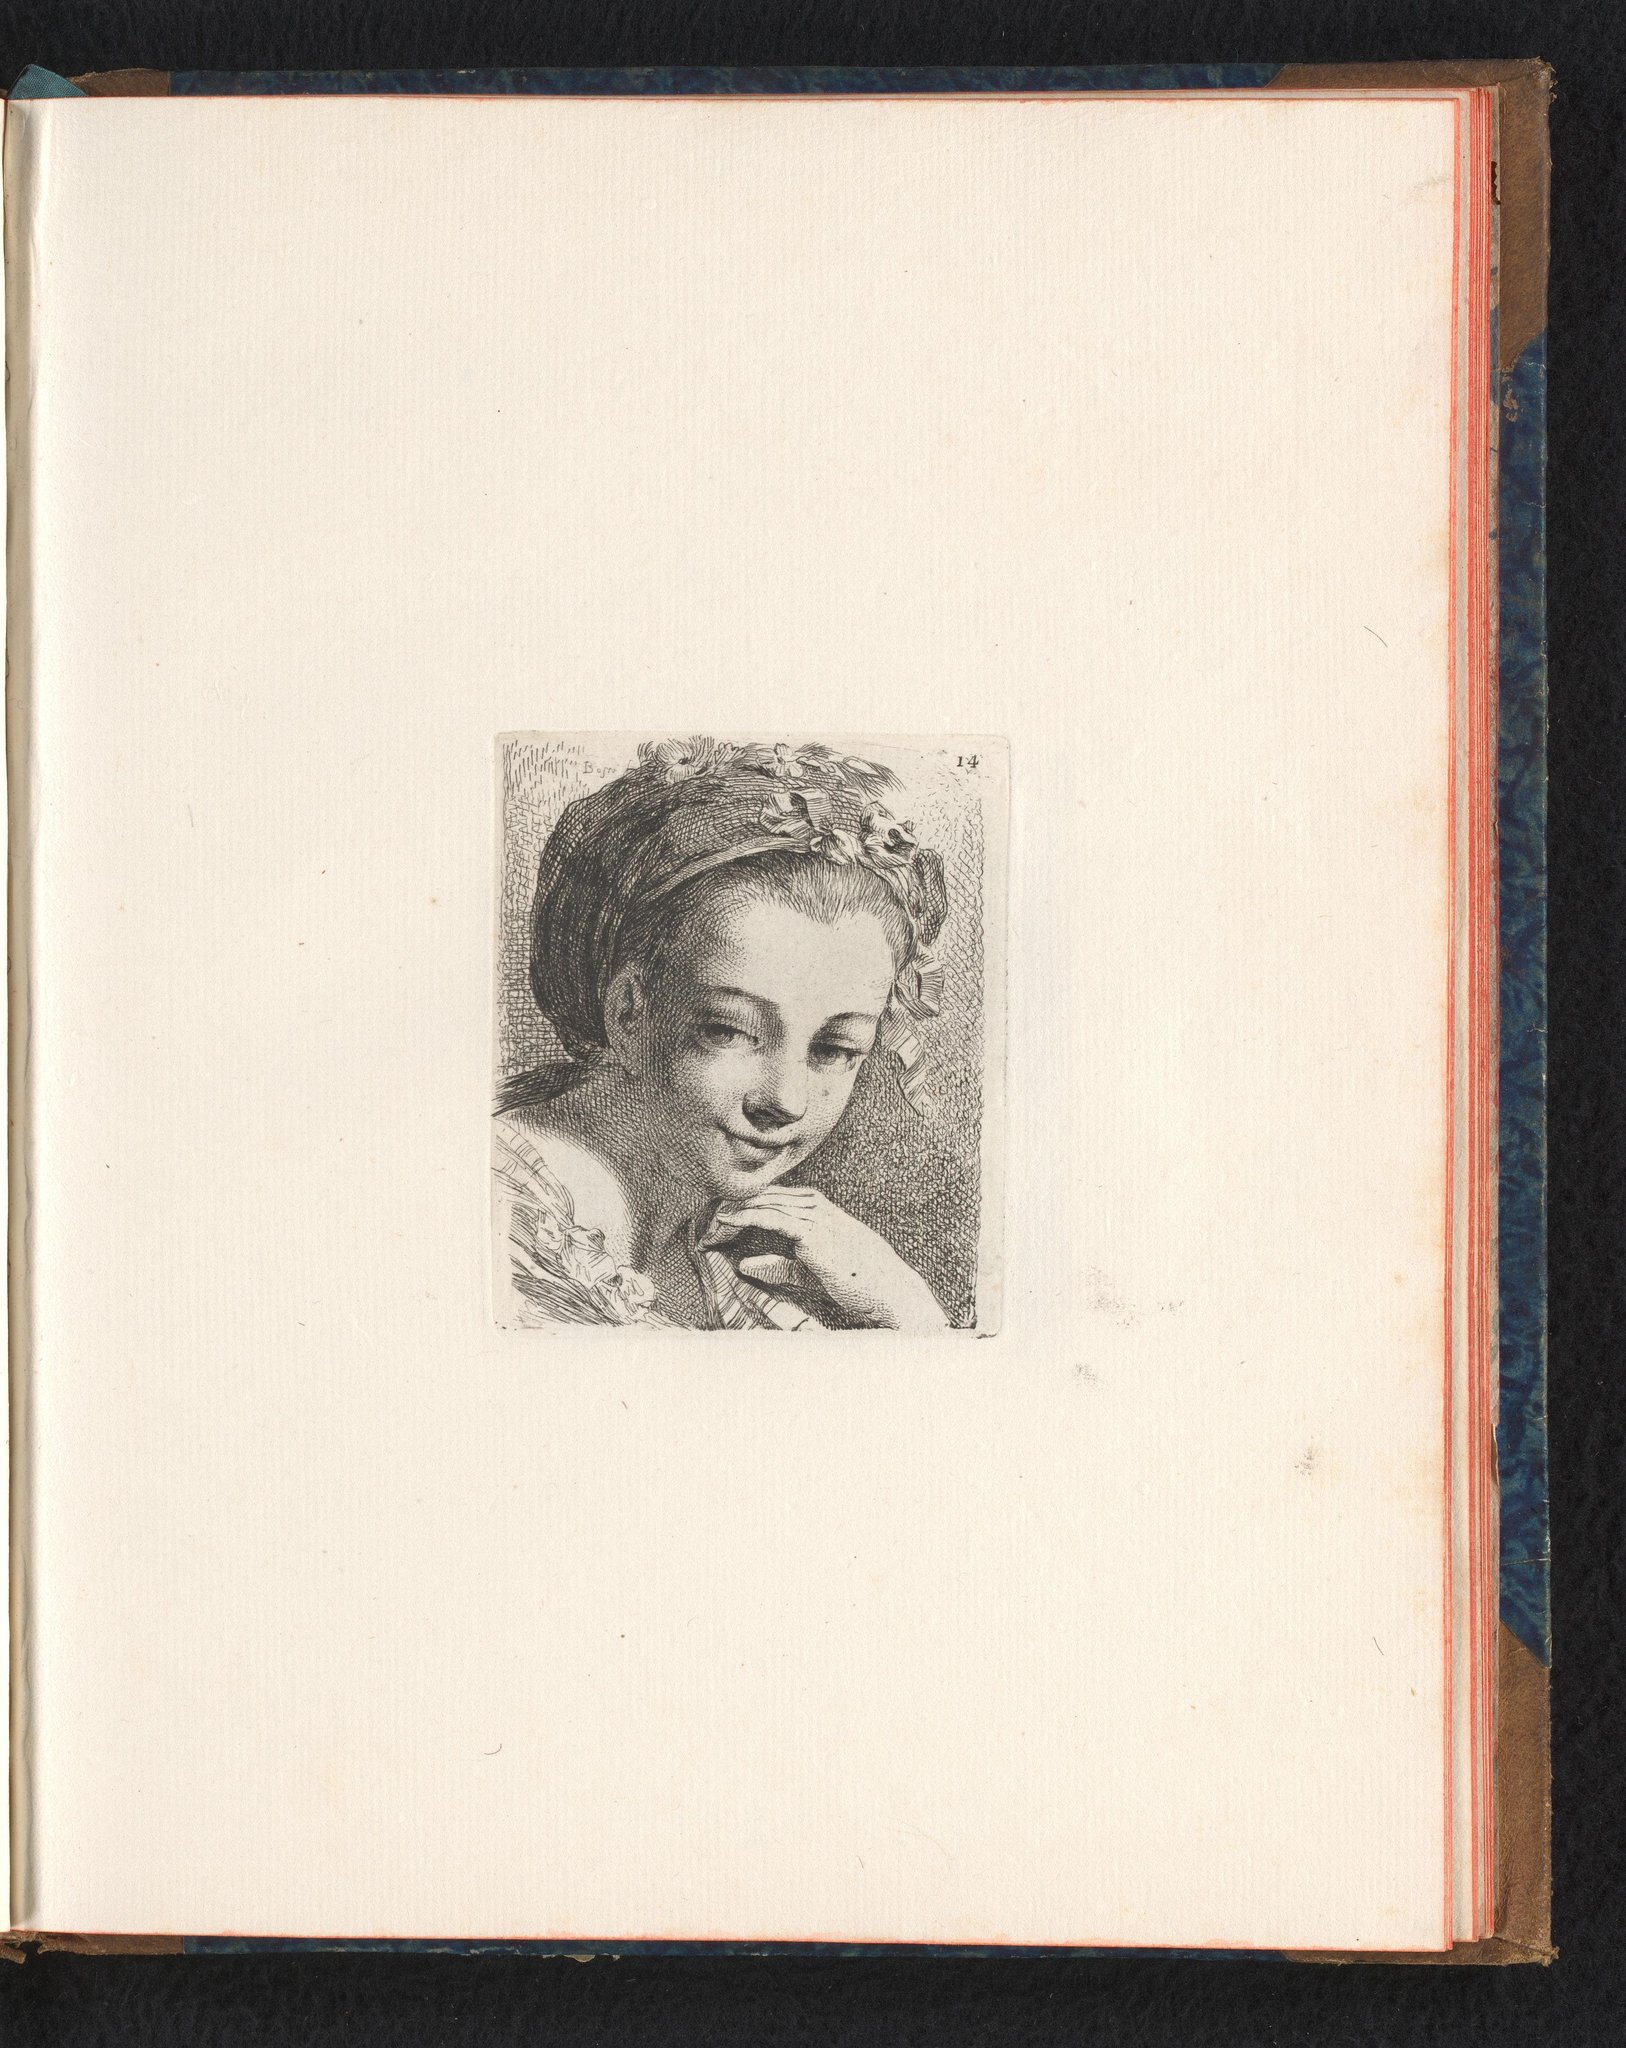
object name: print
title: Raccolta di teste, pensieri, trofei e prove varie d'acquaforte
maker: benigno bossi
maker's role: print maker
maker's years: 1727-1792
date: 1754-1772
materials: paper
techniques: etching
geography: parma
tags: head (human)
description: De prent is waarschijnlijk in de eerdere staat uitgegeven onder de serietitel: Prove d"aqua forte. De prent is in de eerdere staat ook uitgegeven onder de serietitel: Raccolta di teste inventate, disegnate ed incise da Benigno Bossi.